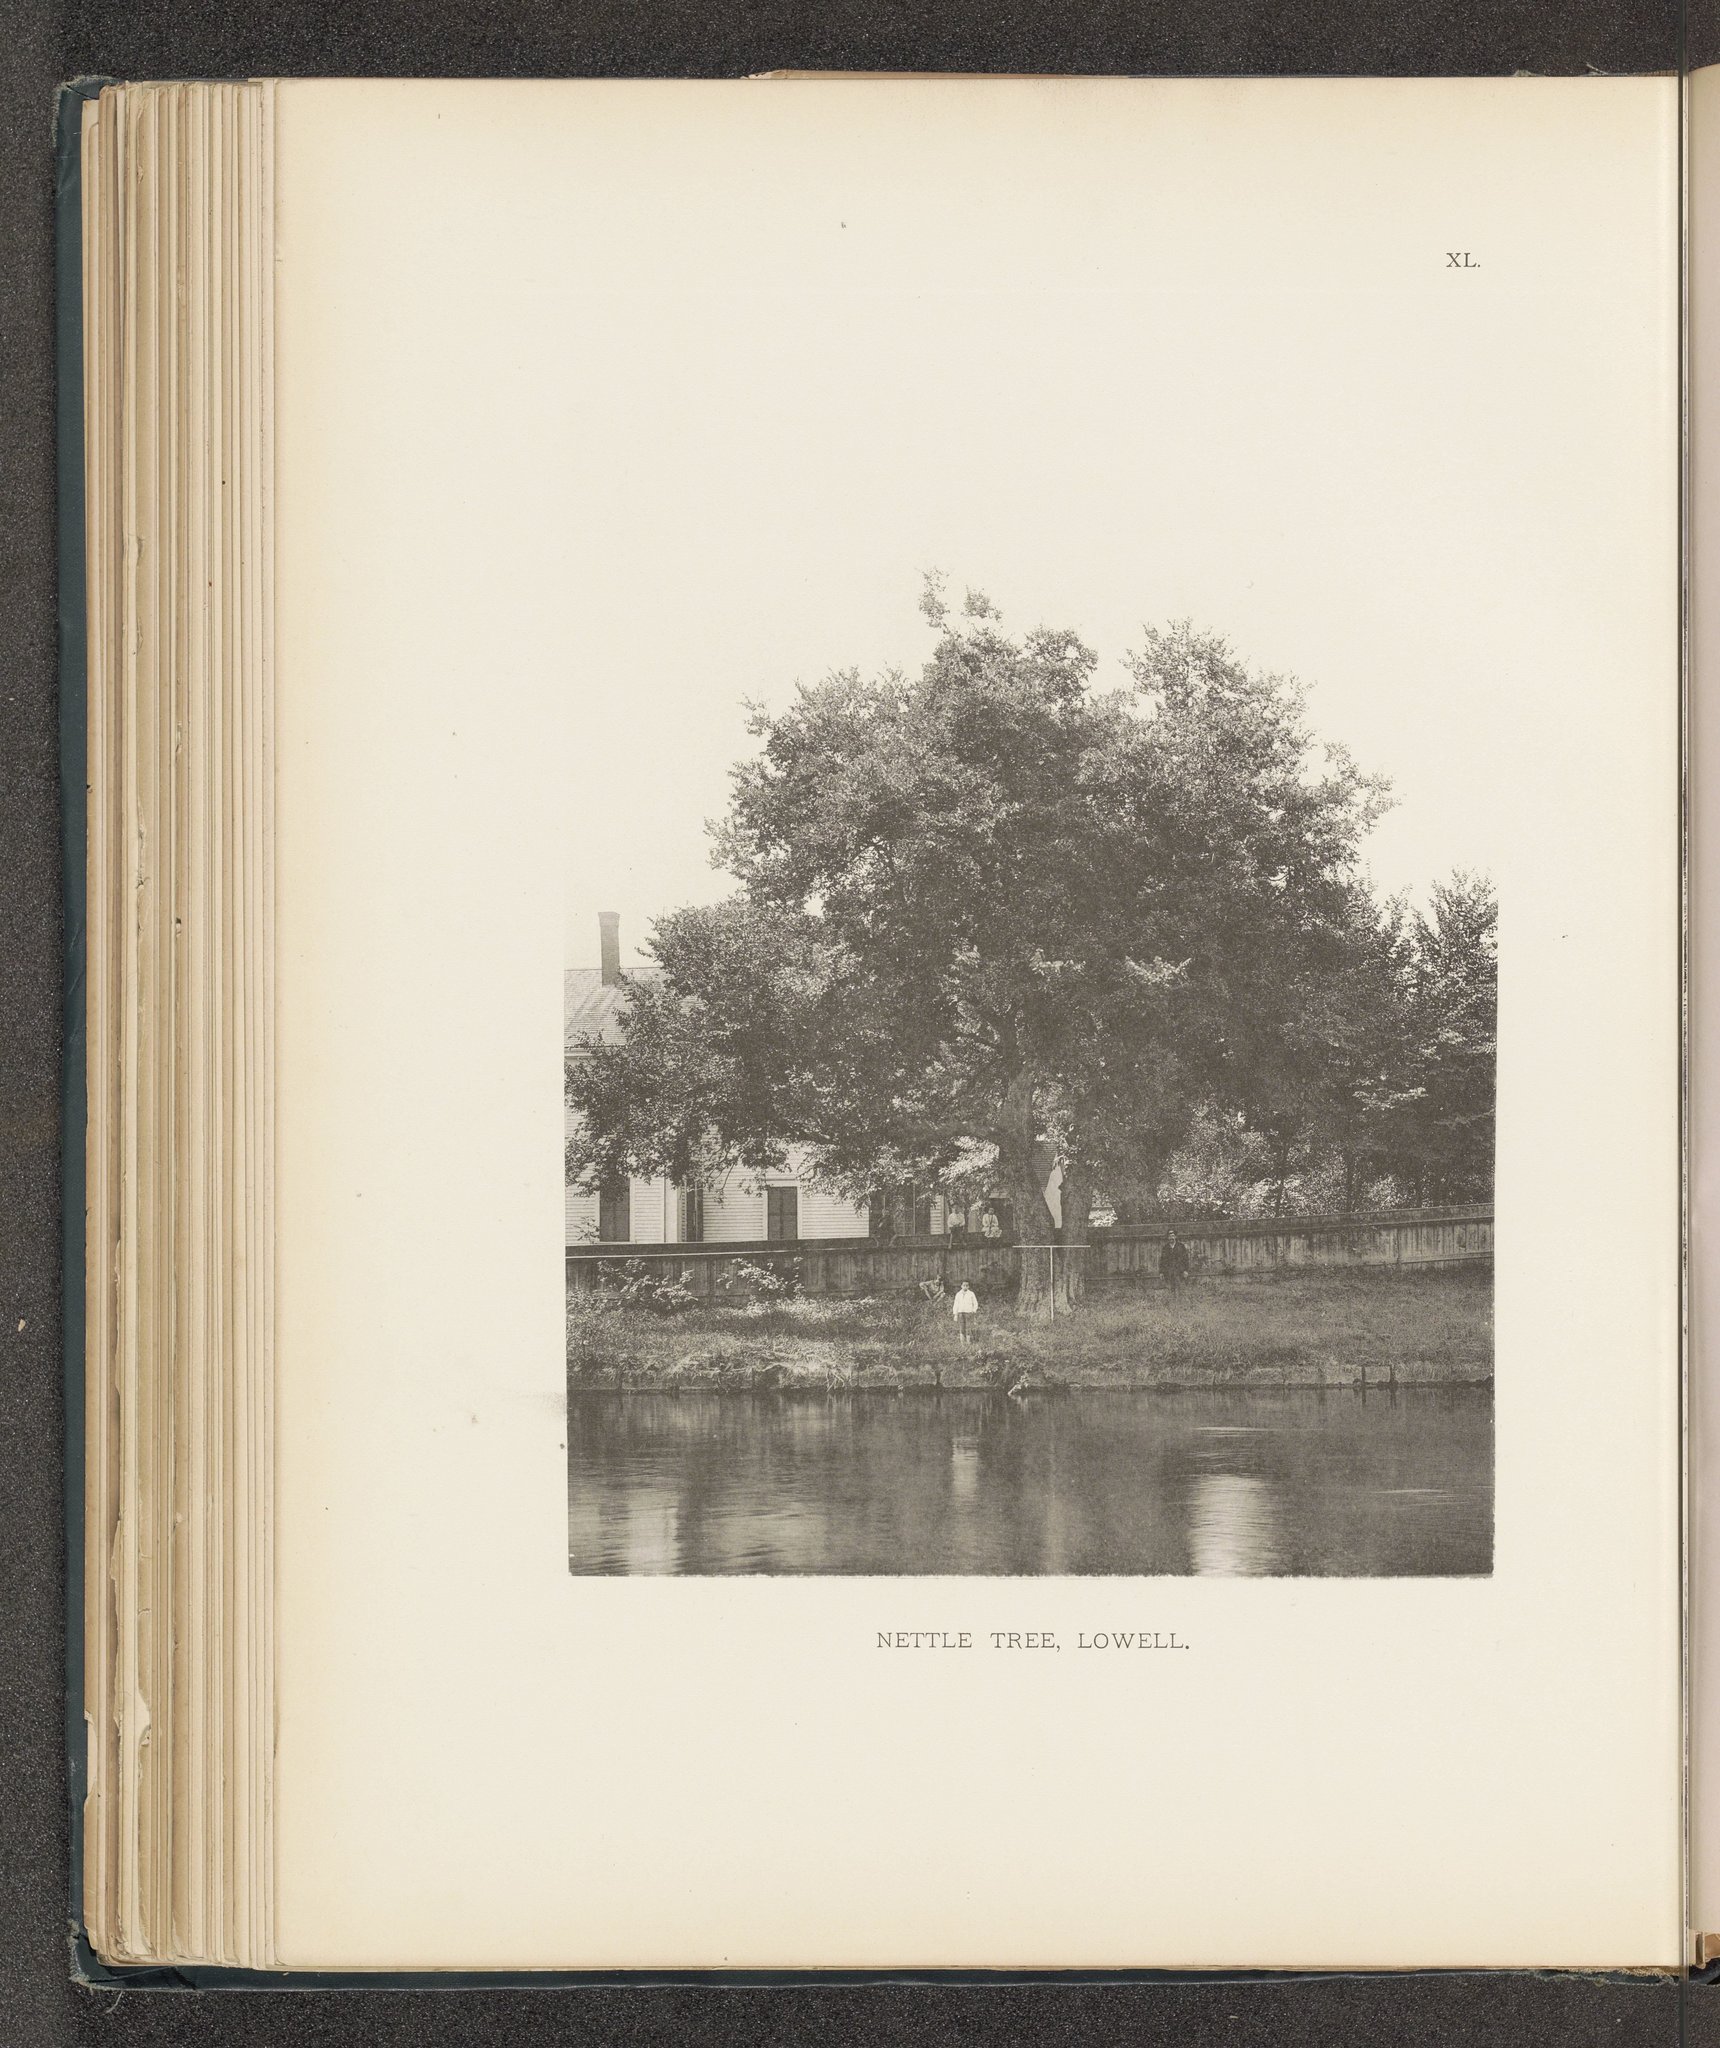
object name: photomechanical print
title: Nettle tree, Lowell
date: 1880-1890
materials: paper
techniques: photograph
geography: lowell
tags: trees, river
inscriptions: number: ‘XL.’